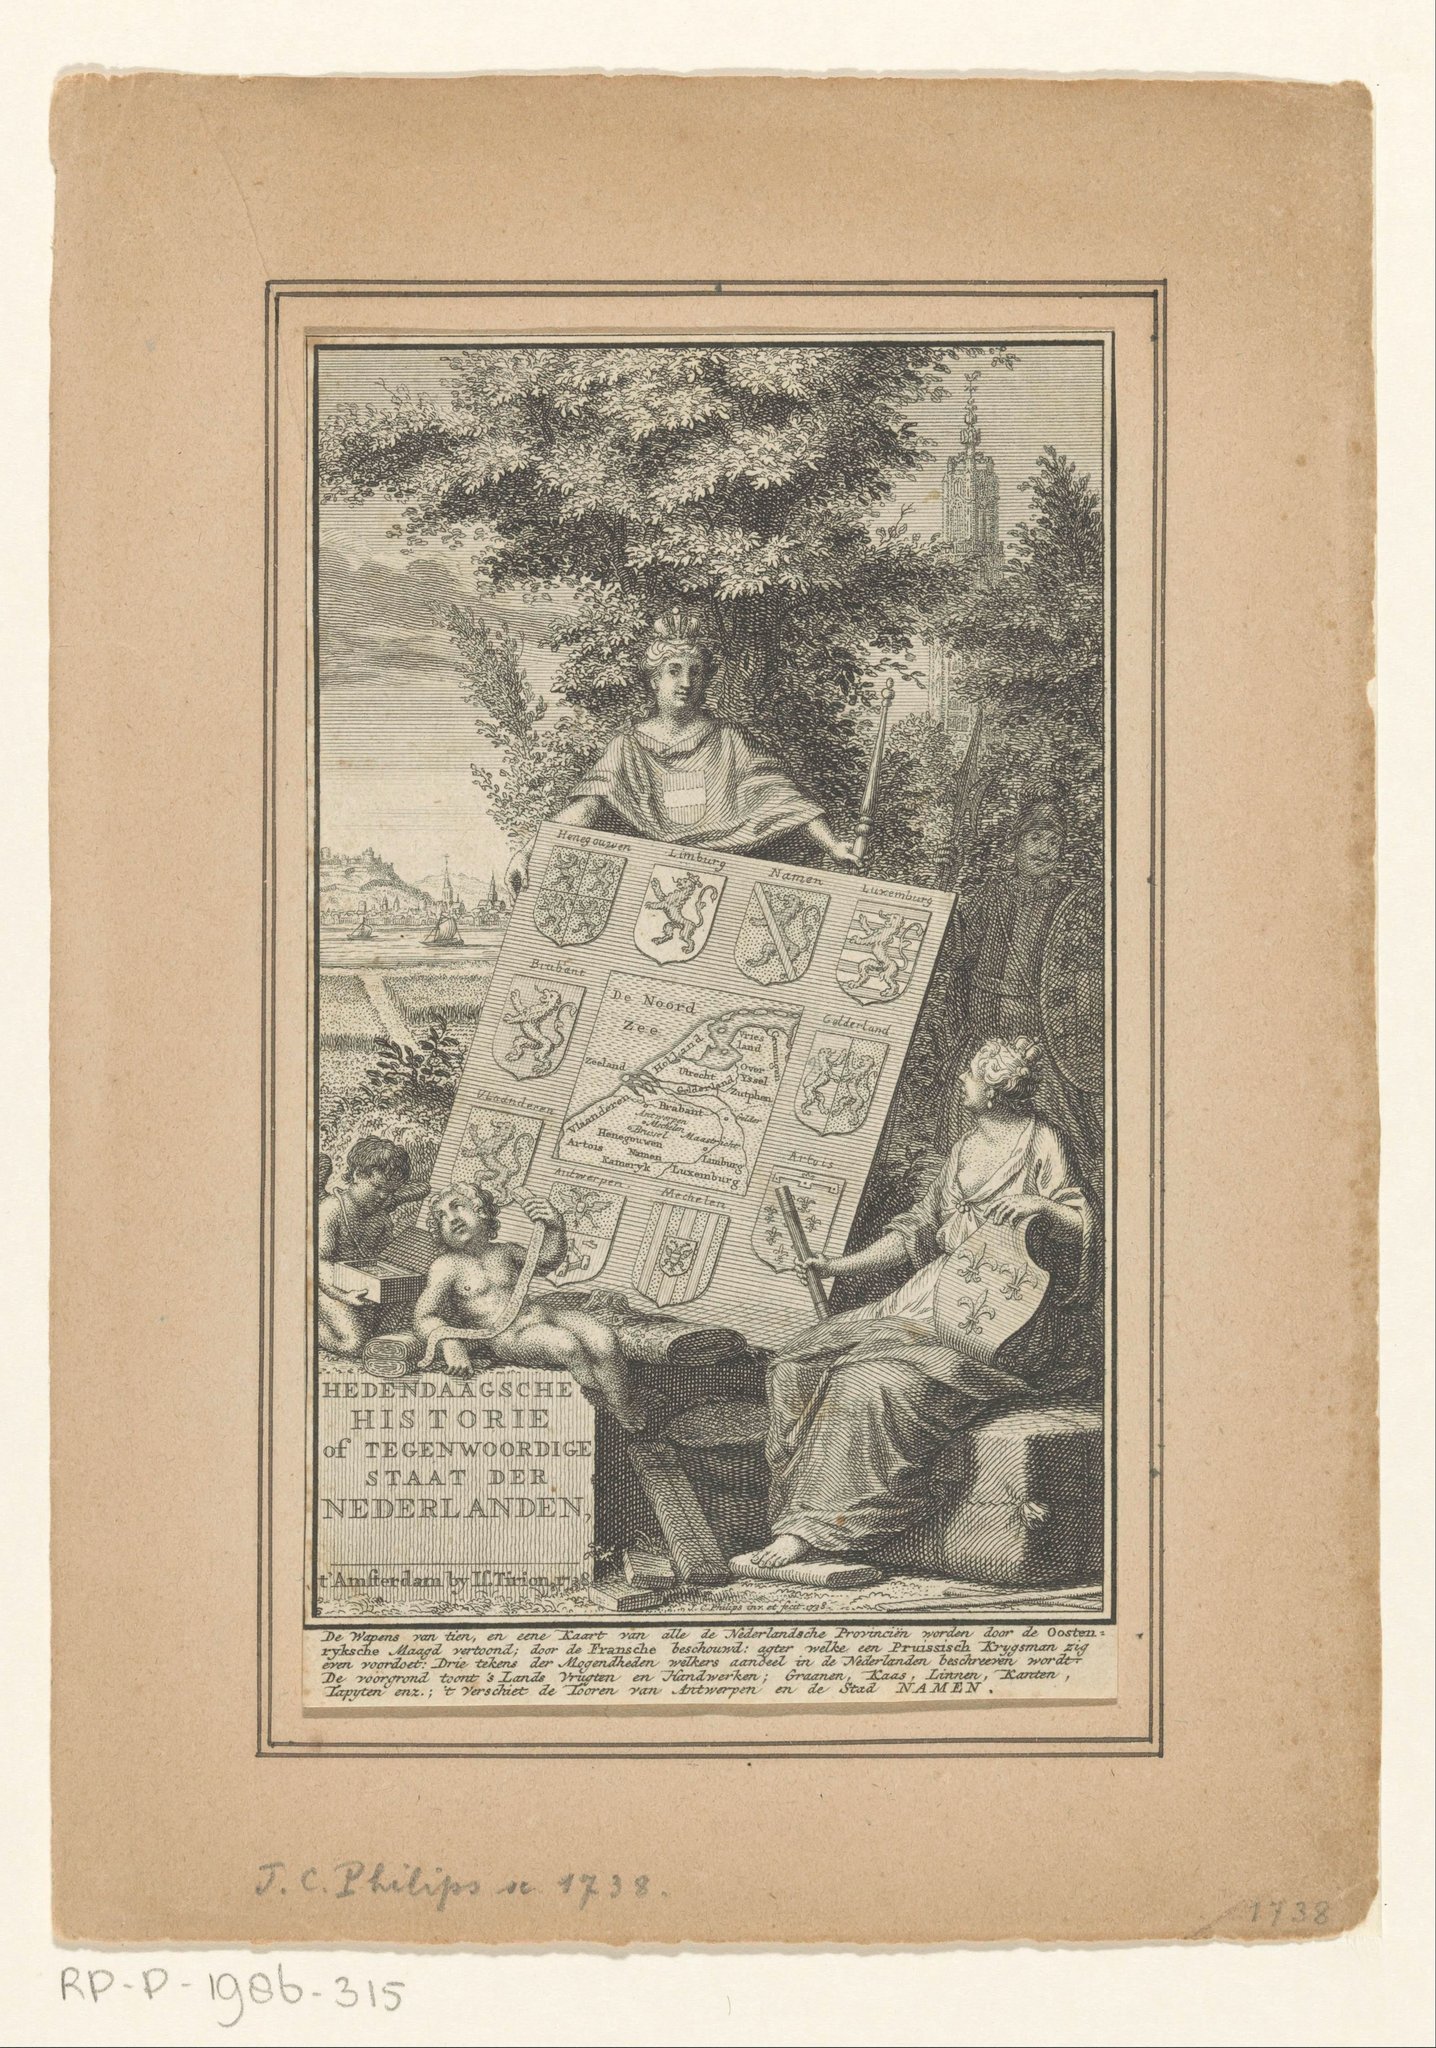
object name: titelblad, titelpagina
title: Oostenrijkse Maagd met de wapenschilden van tien Nederlandse Provincieën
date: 1738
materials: paper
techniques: engraving, etching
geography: amsterdam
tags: personifications of countries, nations, states, districts, etc., coat of arms (as symbol of the state, etc.) (+ province; provincial), austria, france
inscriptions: collector's mark: Lugt 2228, collector's mark: Lugt 2760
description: Landschap met de Oostenrijkse Maagd. Zij toont de Franse Maagd een kaart met de wapenschilden van tien Nederlandse Provinciën en een landkaart. Op de achtergrond een gezicht op Antwerpen. In de marge een vijfregelig onderschrift in het Nederlands.